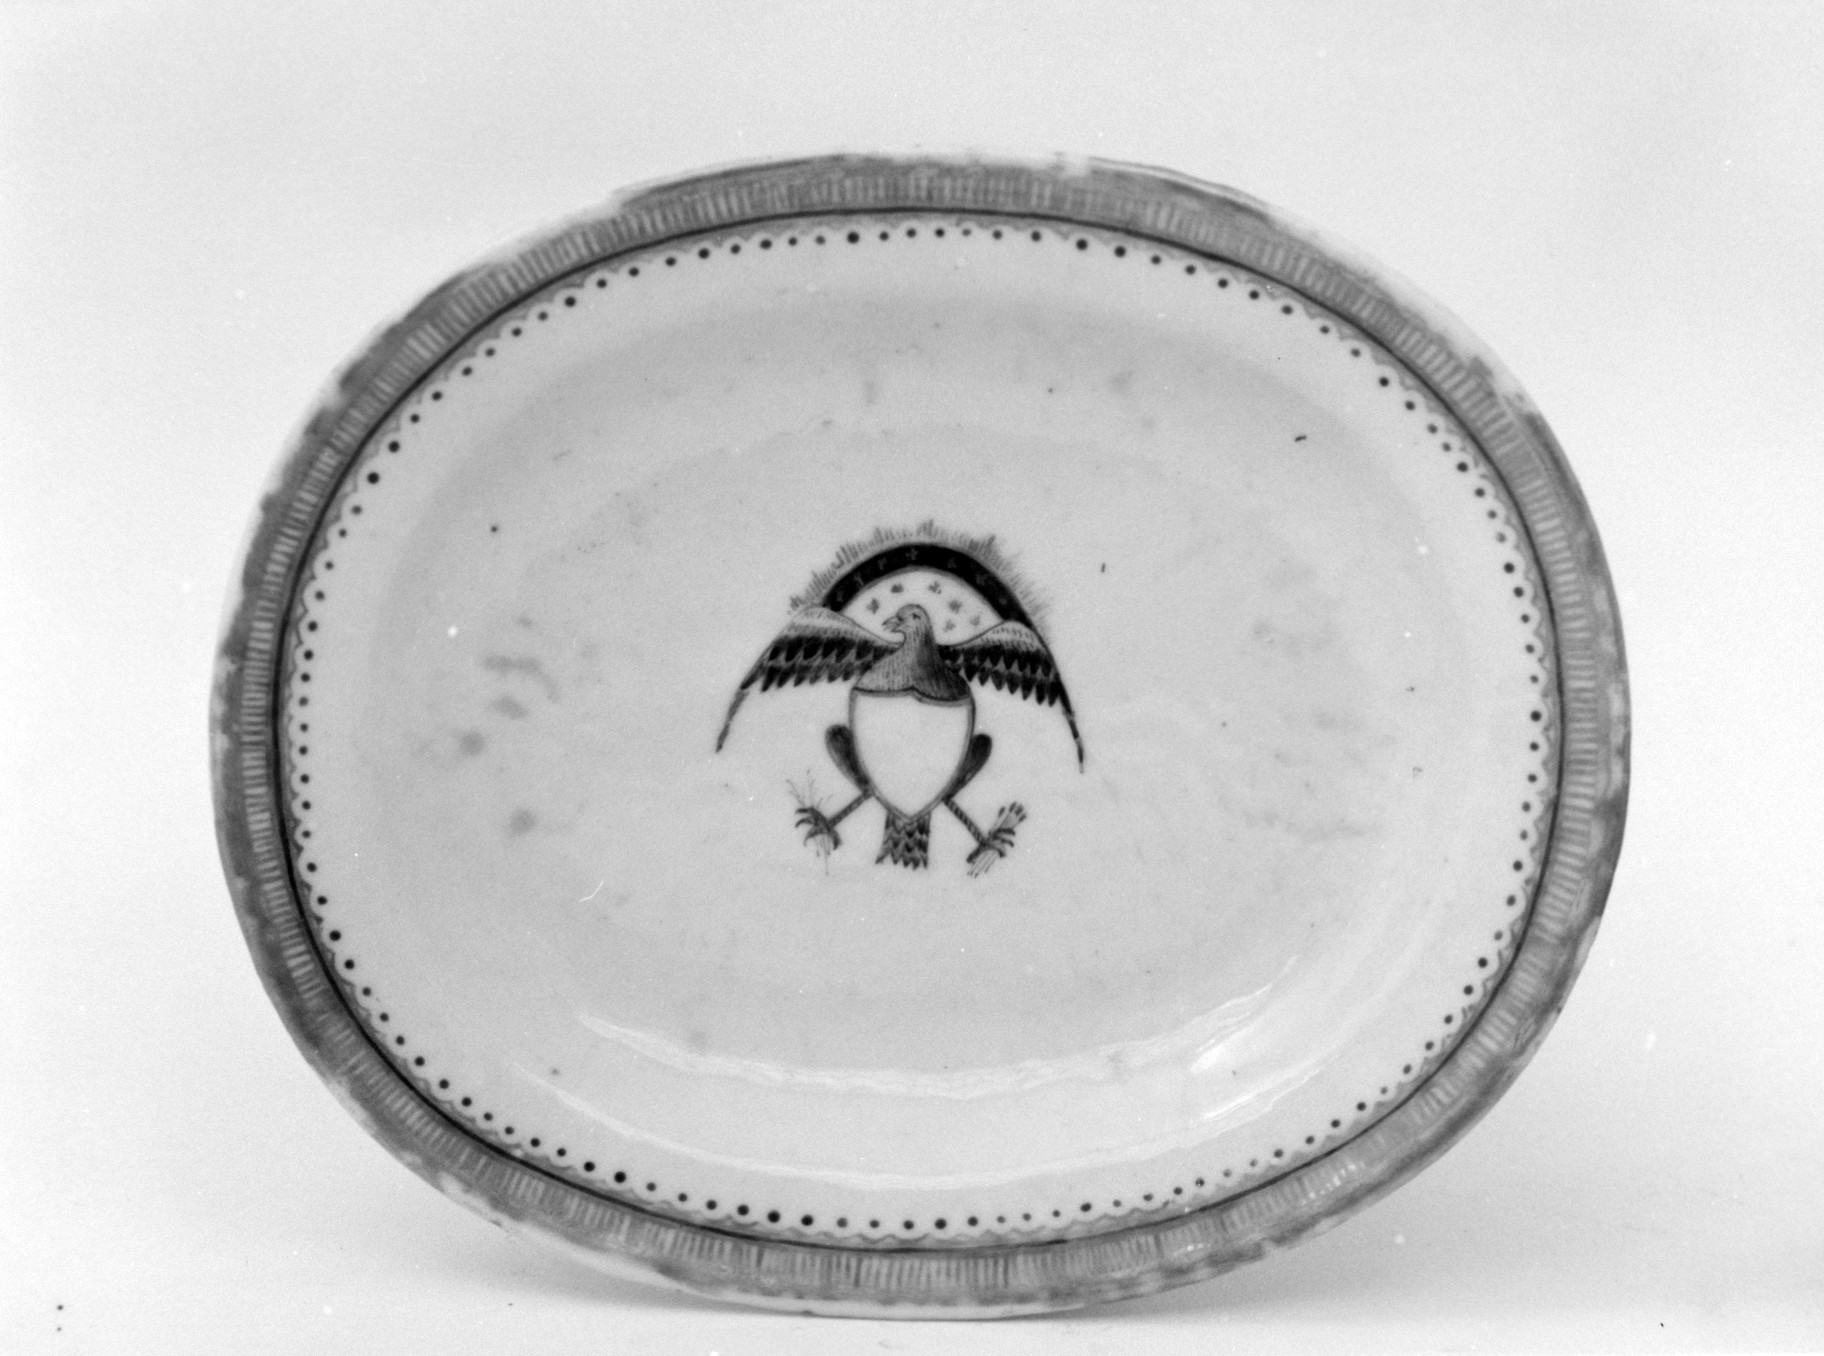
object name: tray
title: Tray (part of a service)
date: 1767-1833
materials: hard paste porcelain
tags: birds